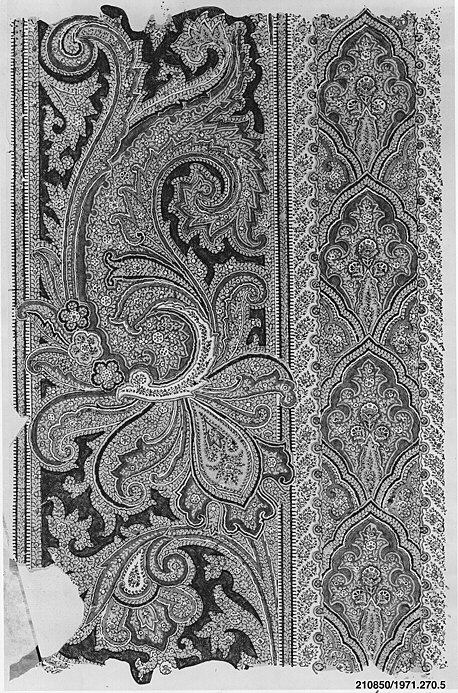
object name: sample book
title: Textile Sample Book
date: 1801-1900